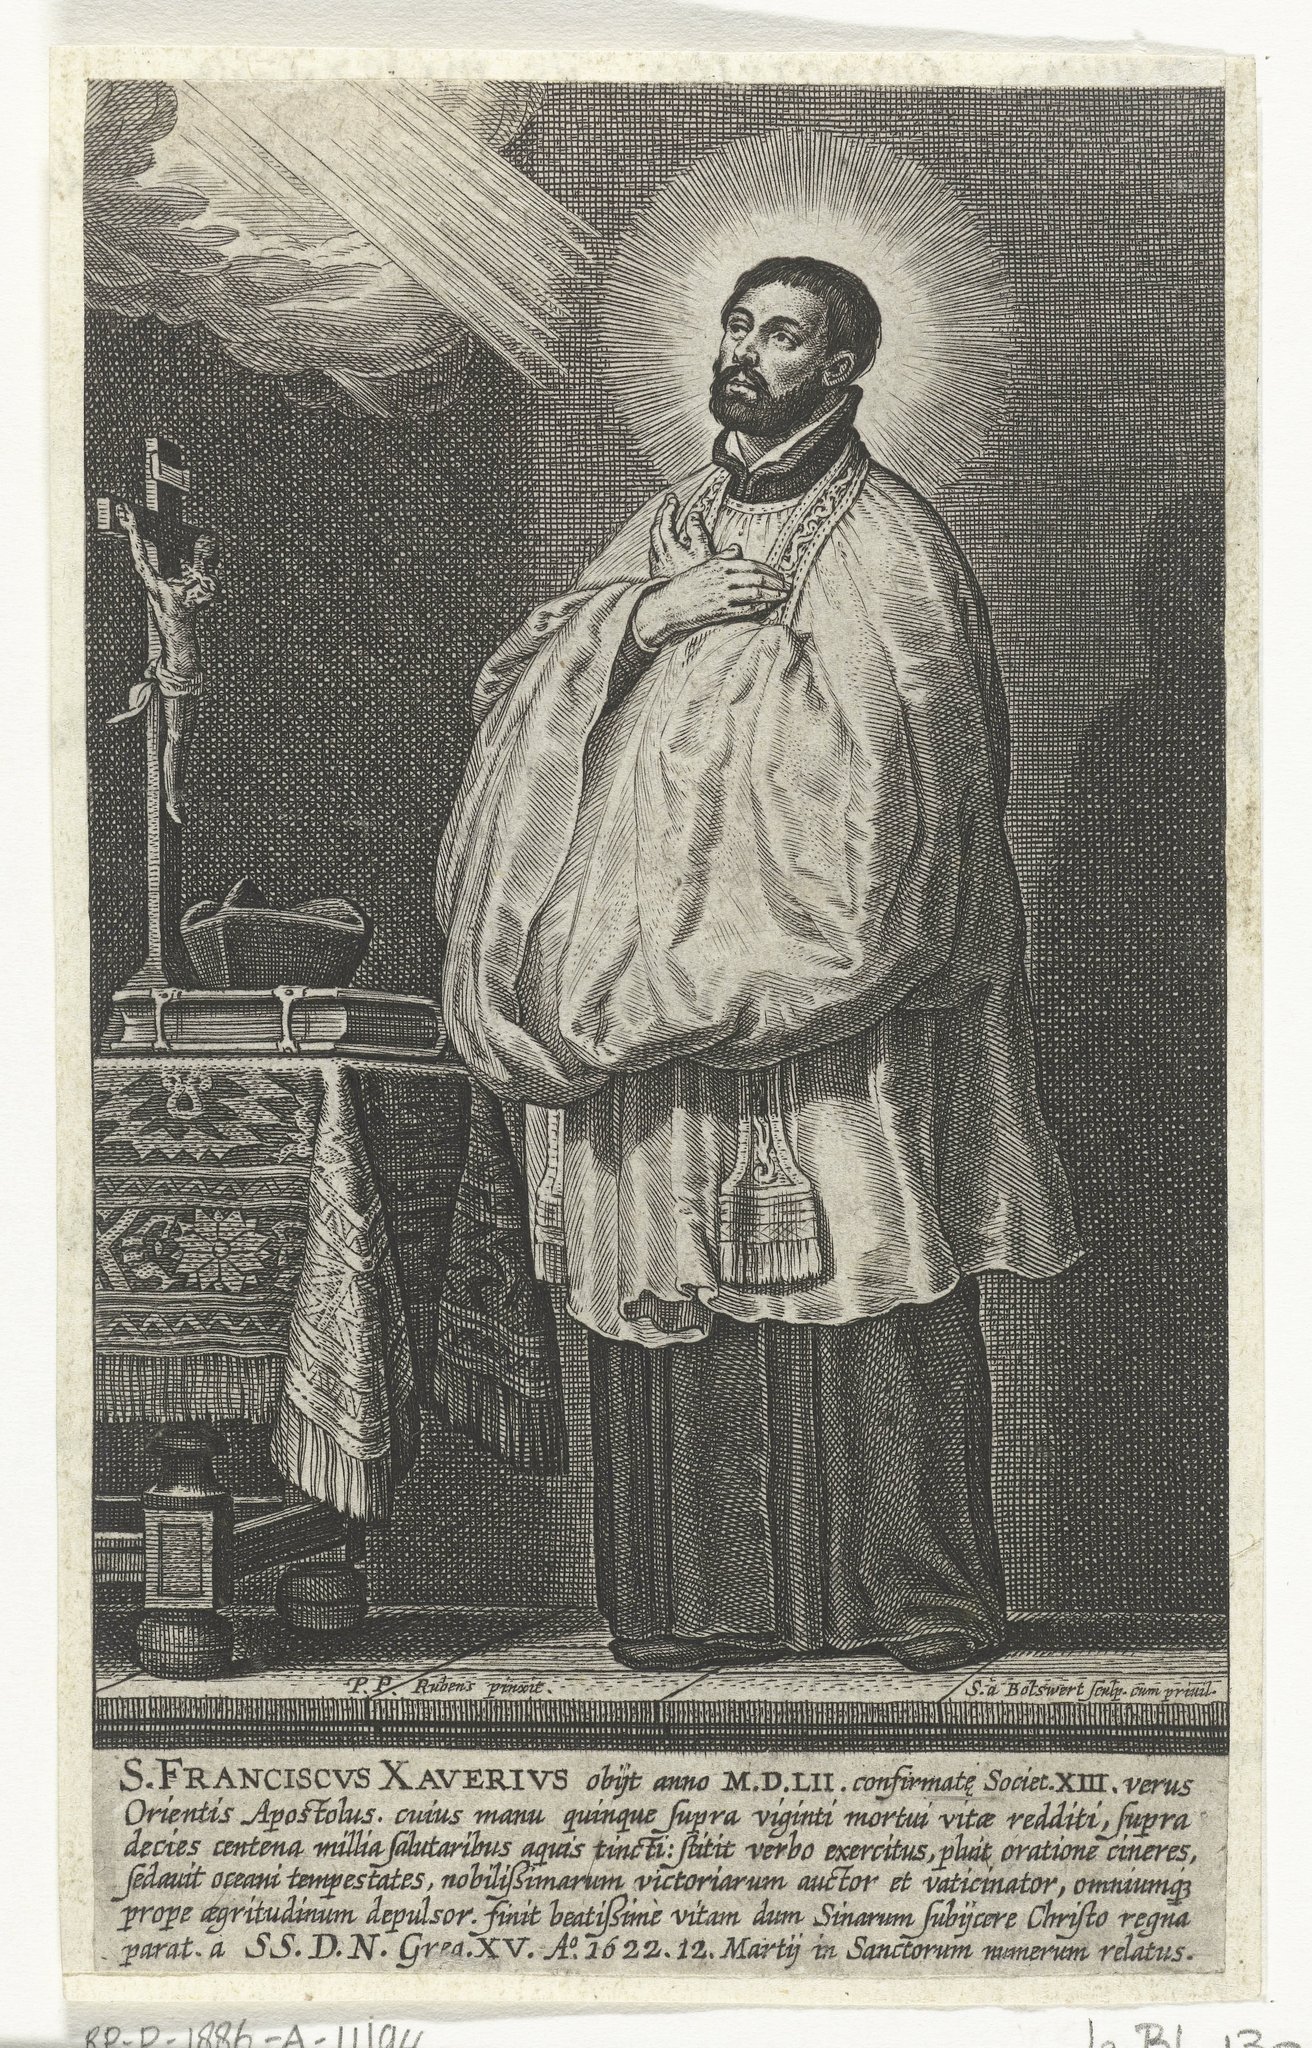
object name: print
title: Heilige Franciscus Xaverius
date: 1622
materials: paper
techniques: engraving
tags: the jesuit missionary francis xavier; possible attributes: cross, crucifix, flaming heart, indian, lily, torch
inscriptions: collector's mark: Lugt 2228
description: De heilige Franciscus Xaverius kijkt in aanbidding naar de hemel. Onder de voorstelling staat een tekst in het Latijn over de verdiensten van de heilige.